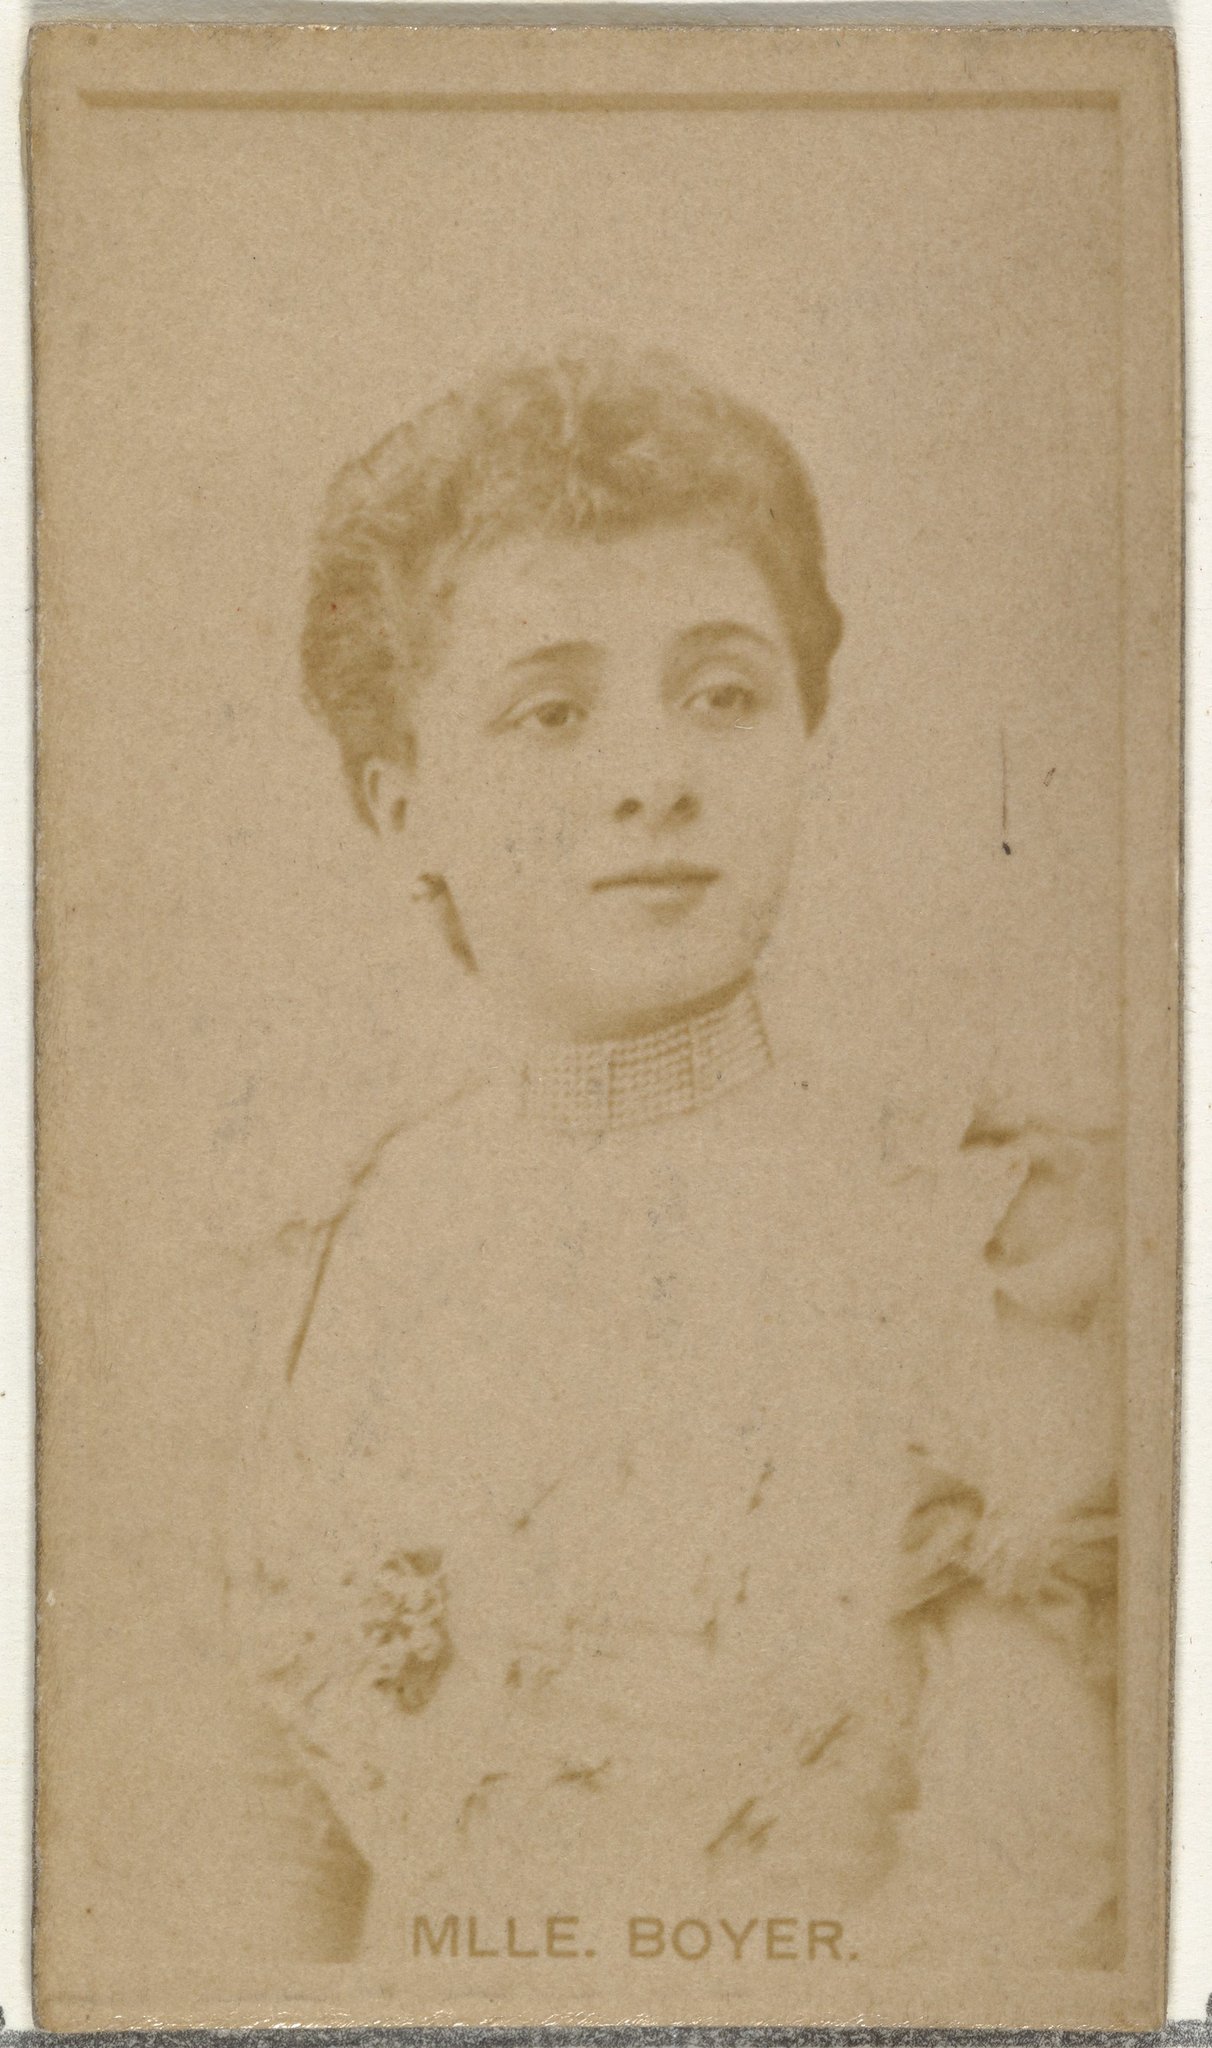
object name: photograph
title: Mlle. Boyer, from the Actors and Actresses series (N145-8) issued by Duke Sons & Co. to promote Duke Cigarettes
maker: w. duke, sons & co.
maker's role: publisher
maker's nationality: american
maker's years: 1870-1920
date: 1891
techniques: albumen silver print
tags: portraits,women,actresses